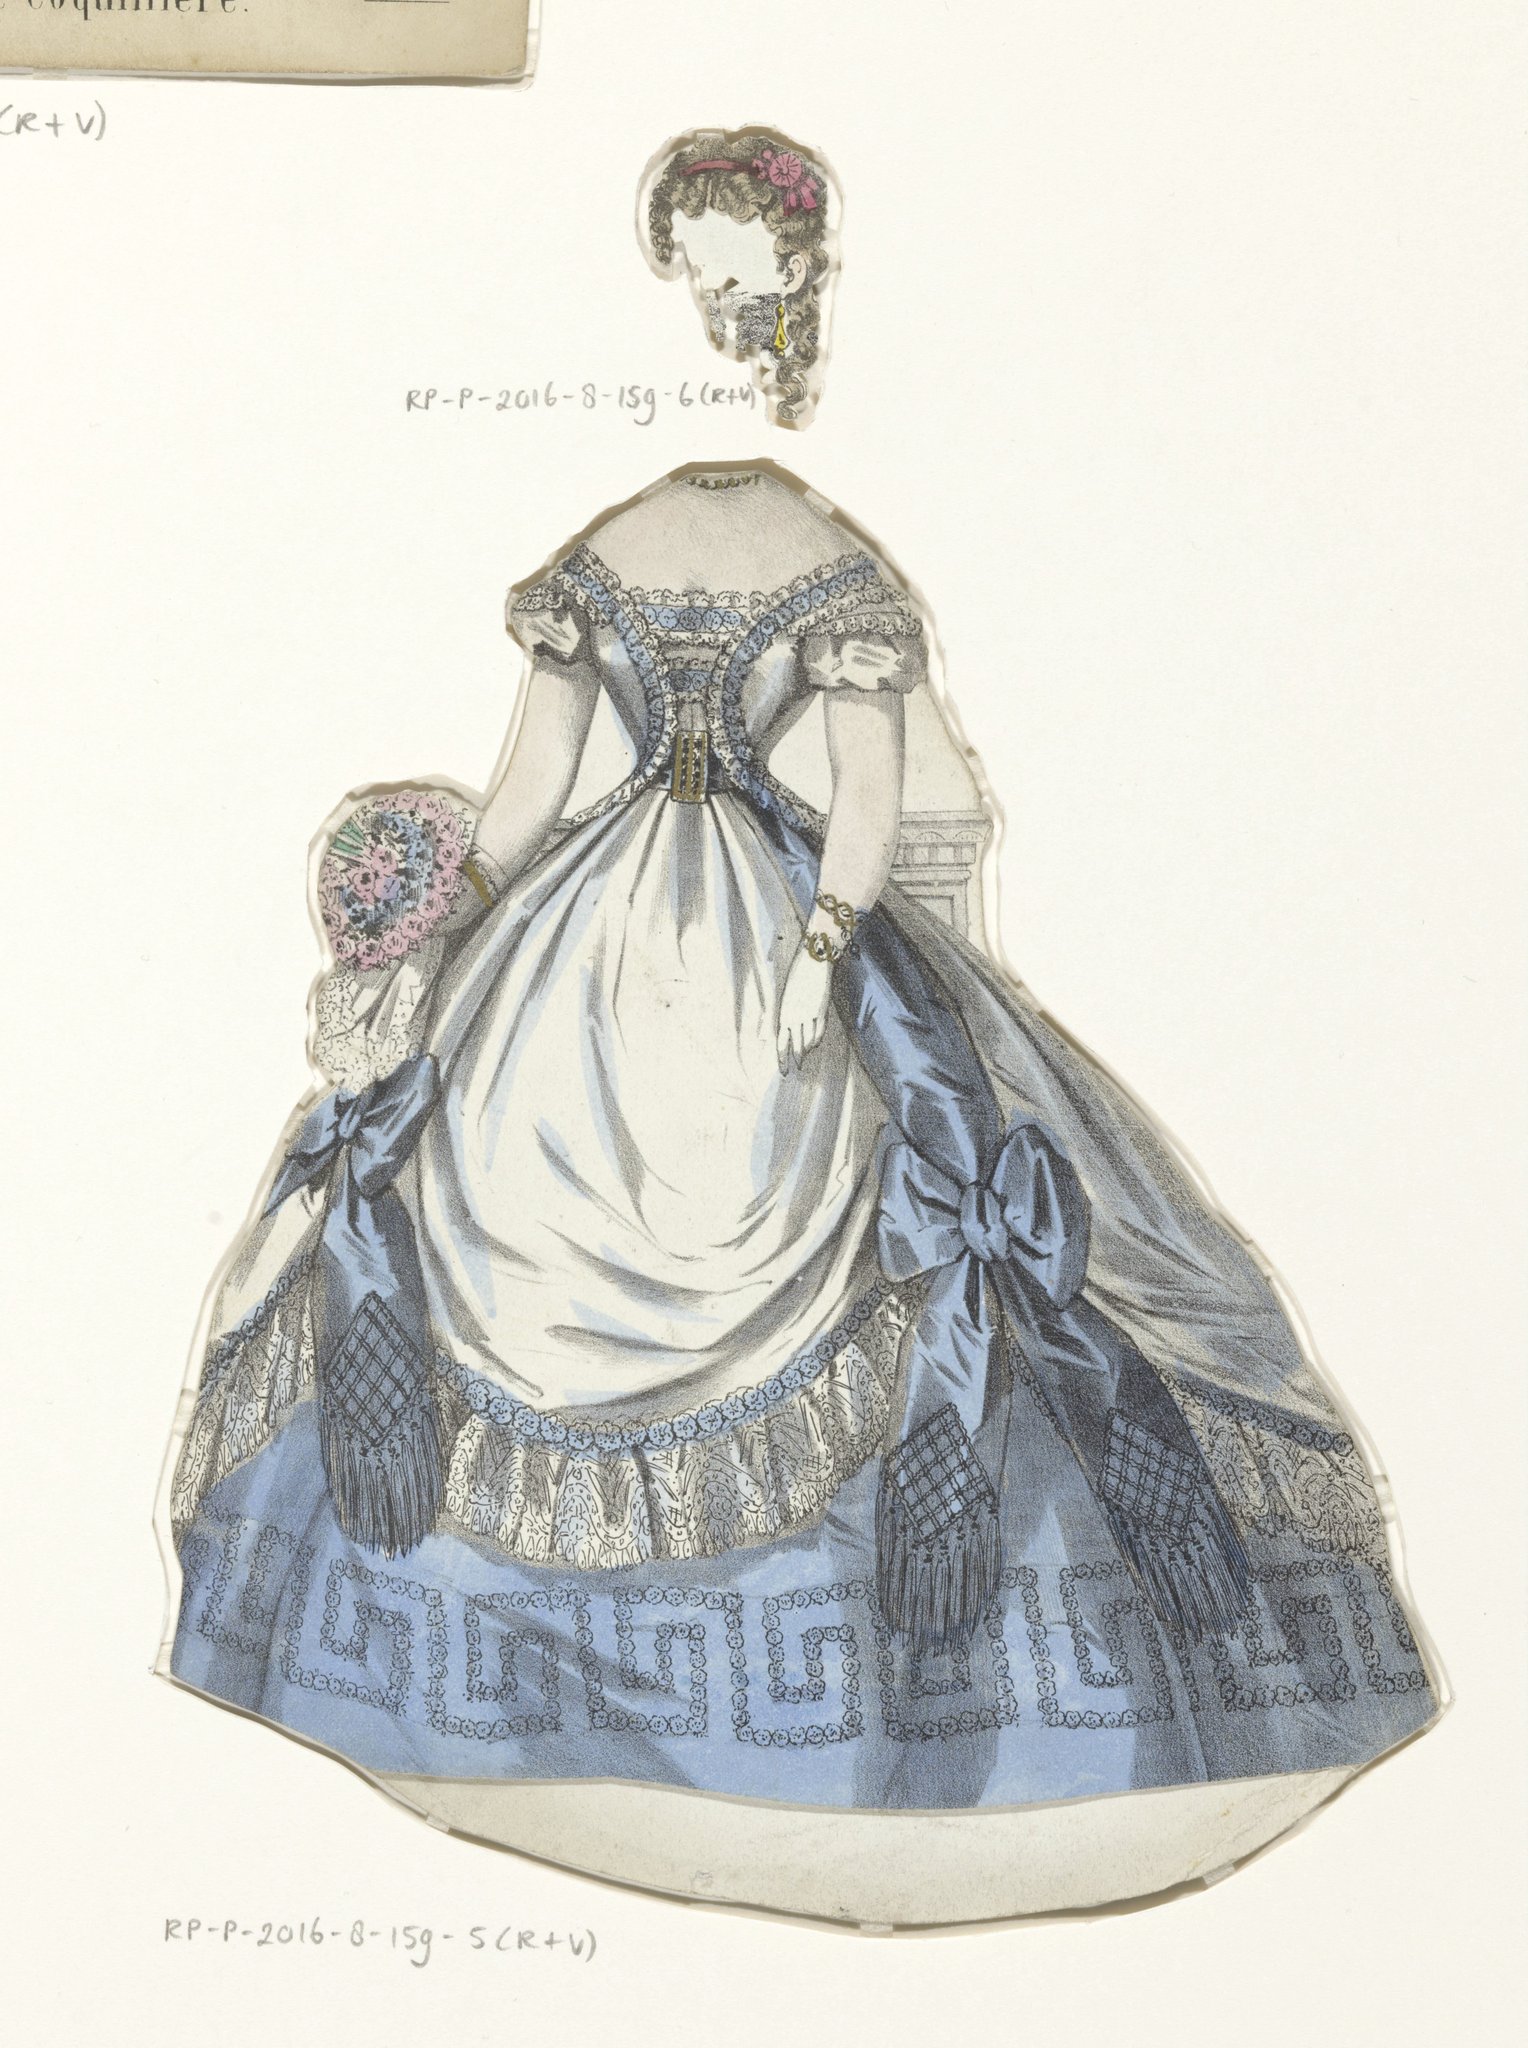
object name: fashion print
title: Jurk voor een uitknippop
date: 1825-1875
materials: paper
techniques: engraving, hand coloring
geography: paris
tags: fashion plates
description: In haar rechterhand een zakdoek en boeket.